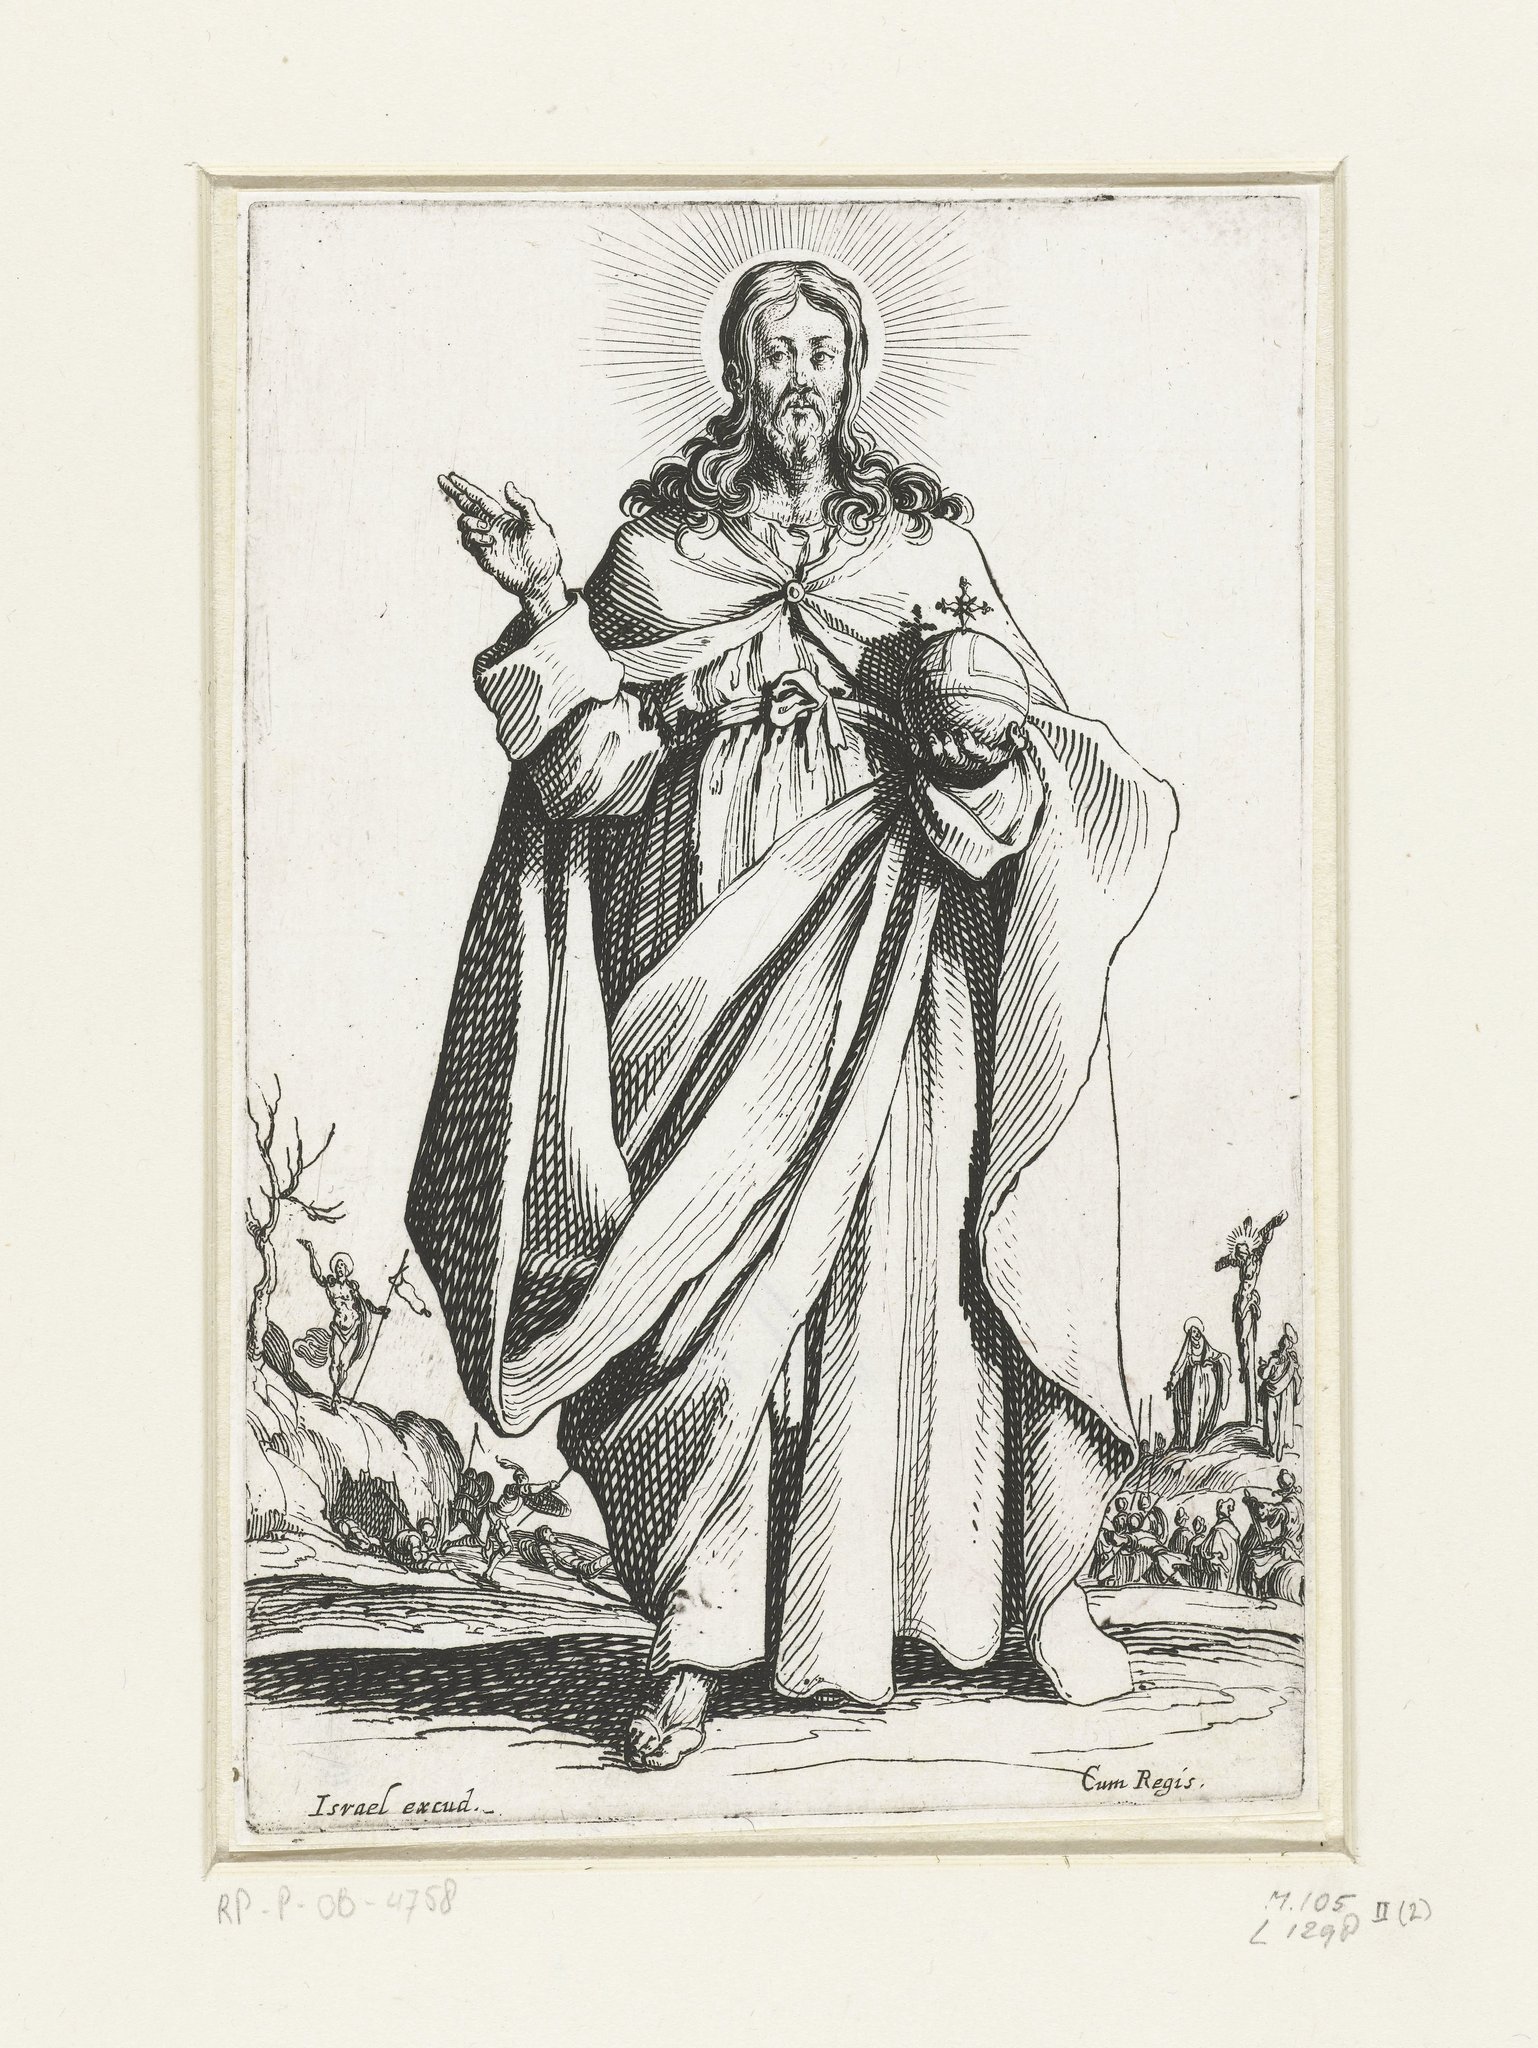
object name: print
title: Christus, Maria en de apostelen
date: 1631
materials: paper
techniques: etching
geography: nancy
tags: 'salvator mundi', making a blessing gesture; an orb in his hand or at his feet, christ, usually holding a banner, arises from the grave; often combined with sleeping and/or frightened soldiers, crucified christ with mary and john on either side of the cross; holy rood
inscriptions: collector's mark: Lugt 240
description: Christus, ten voeten uit, in de linkerhand een rijksappel, met de rechterhand een zegenend gebaar makend. Op de achtergrond rechts zijn kruisiging en links zijn opstanding. Deze prent is onderdeel van een reeks van 16 prenten, bestaande uit een titelblad en 15 portretten, voorstellende Christus, Maria en de apostelen.